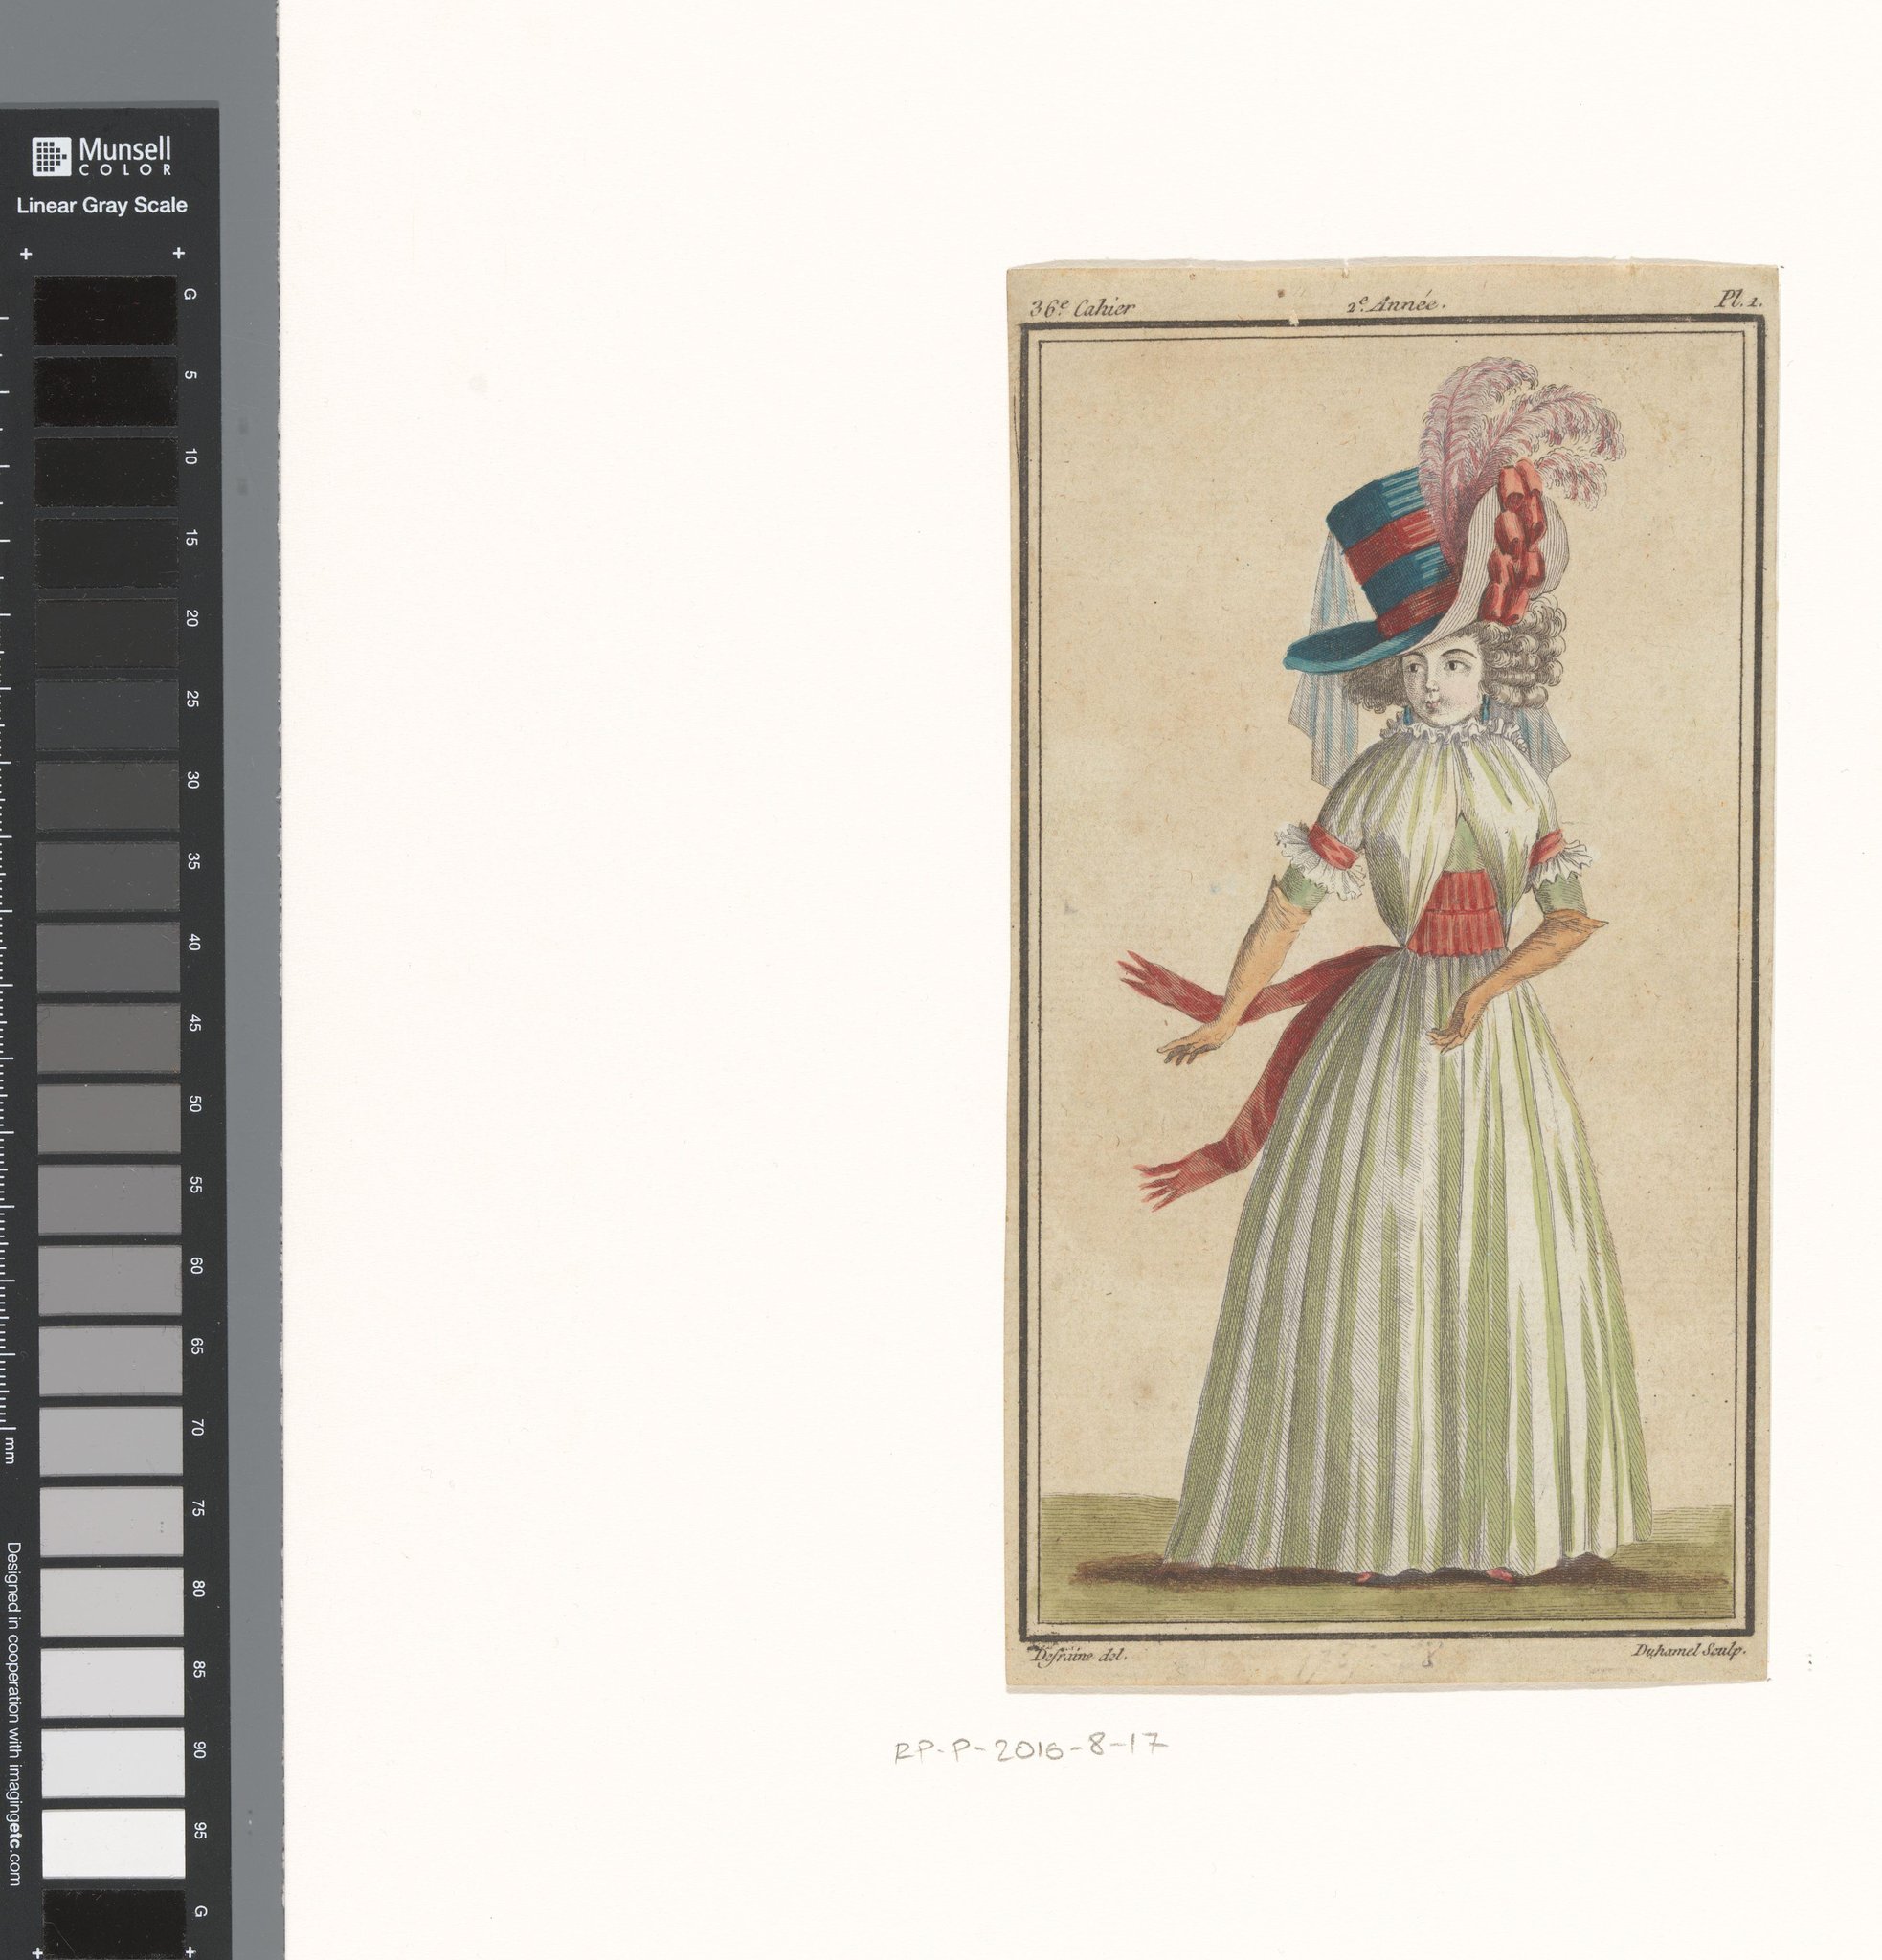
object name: fashion print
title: Magasin des Modes Nouvelles Françaises et Anglaises, 10 novembre 1787, 36e cahier, 2e année, Pl. 1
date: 1787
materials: paper, ink, watercolor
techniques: etching, hand coloring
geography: paris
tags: gloves, mittens (long gloves) (+ women's clothes), border, ribbon, braid (+ women's clothes), fashion plates, head-gear: hat (+ women's clothes), dress, gown (+ women's clothes), belt, girdle, waistband (+ women's clothes)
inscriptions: collector's mark: Lugt 2228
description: Staande vrouw gekleed in een 'chemise à la vestale' van witte mousseline, een breed rood lint als ceintuur. Op het hoofd een hoed 'à la Tarare'. De prent maakt deel uit van het 36e Cahier, 2e année, uit de serie Magasin des Modes Nouvelles Françaises et Anglaises. De serie bestaat uit 172 modeprenten, uitgegeven door Buisson, Parijs, 20 novembre 1786 - 21 décembre 1789.